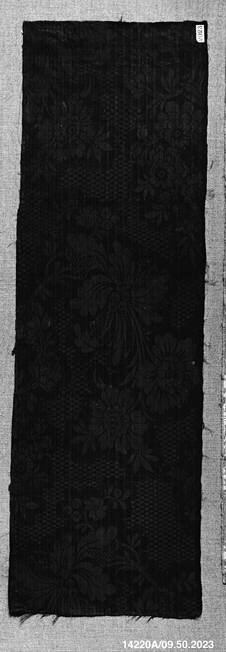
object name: piece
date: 1701-1733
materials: silk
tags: flowers,leaves